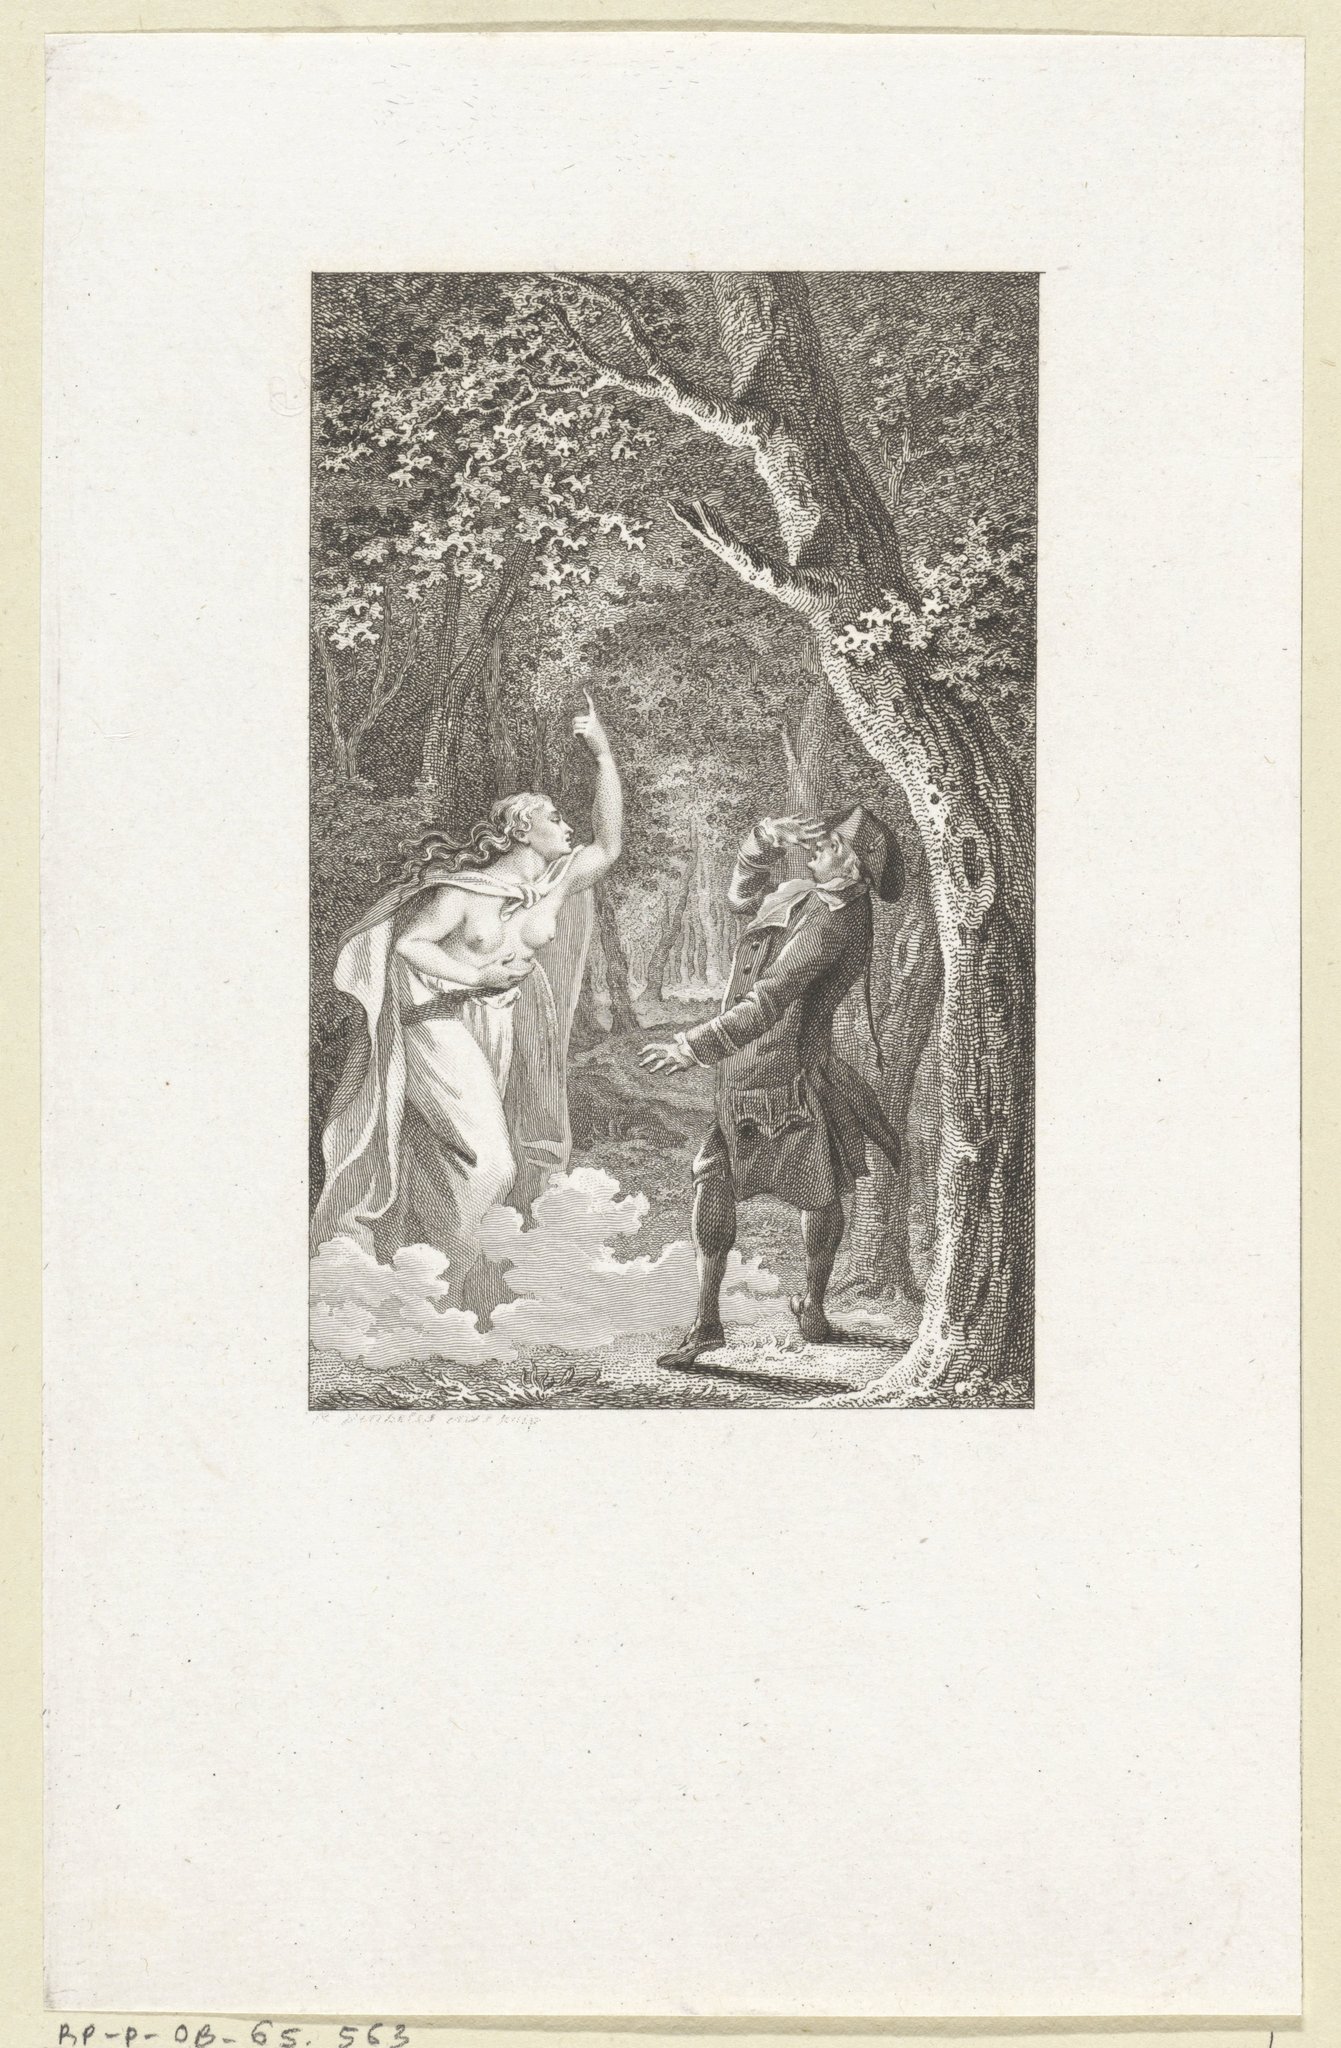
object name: print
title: In een bos verschijnt de geest van Constantia aan Ferdinand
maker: reinier vinkeles (i)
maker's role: draughtsman, print maker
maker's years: 1741-1816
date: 1785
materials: paper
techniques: engraving, etching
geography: amsterdam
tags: forest, wood, spirit, ghost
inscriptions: collector's mark: Lugt 240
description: Deze prent is ook gebruikt als illustratie in: Rhĳnvis, Feith. Ferdinand et Constance. Amsterdam: Johannes Allart, 1785.